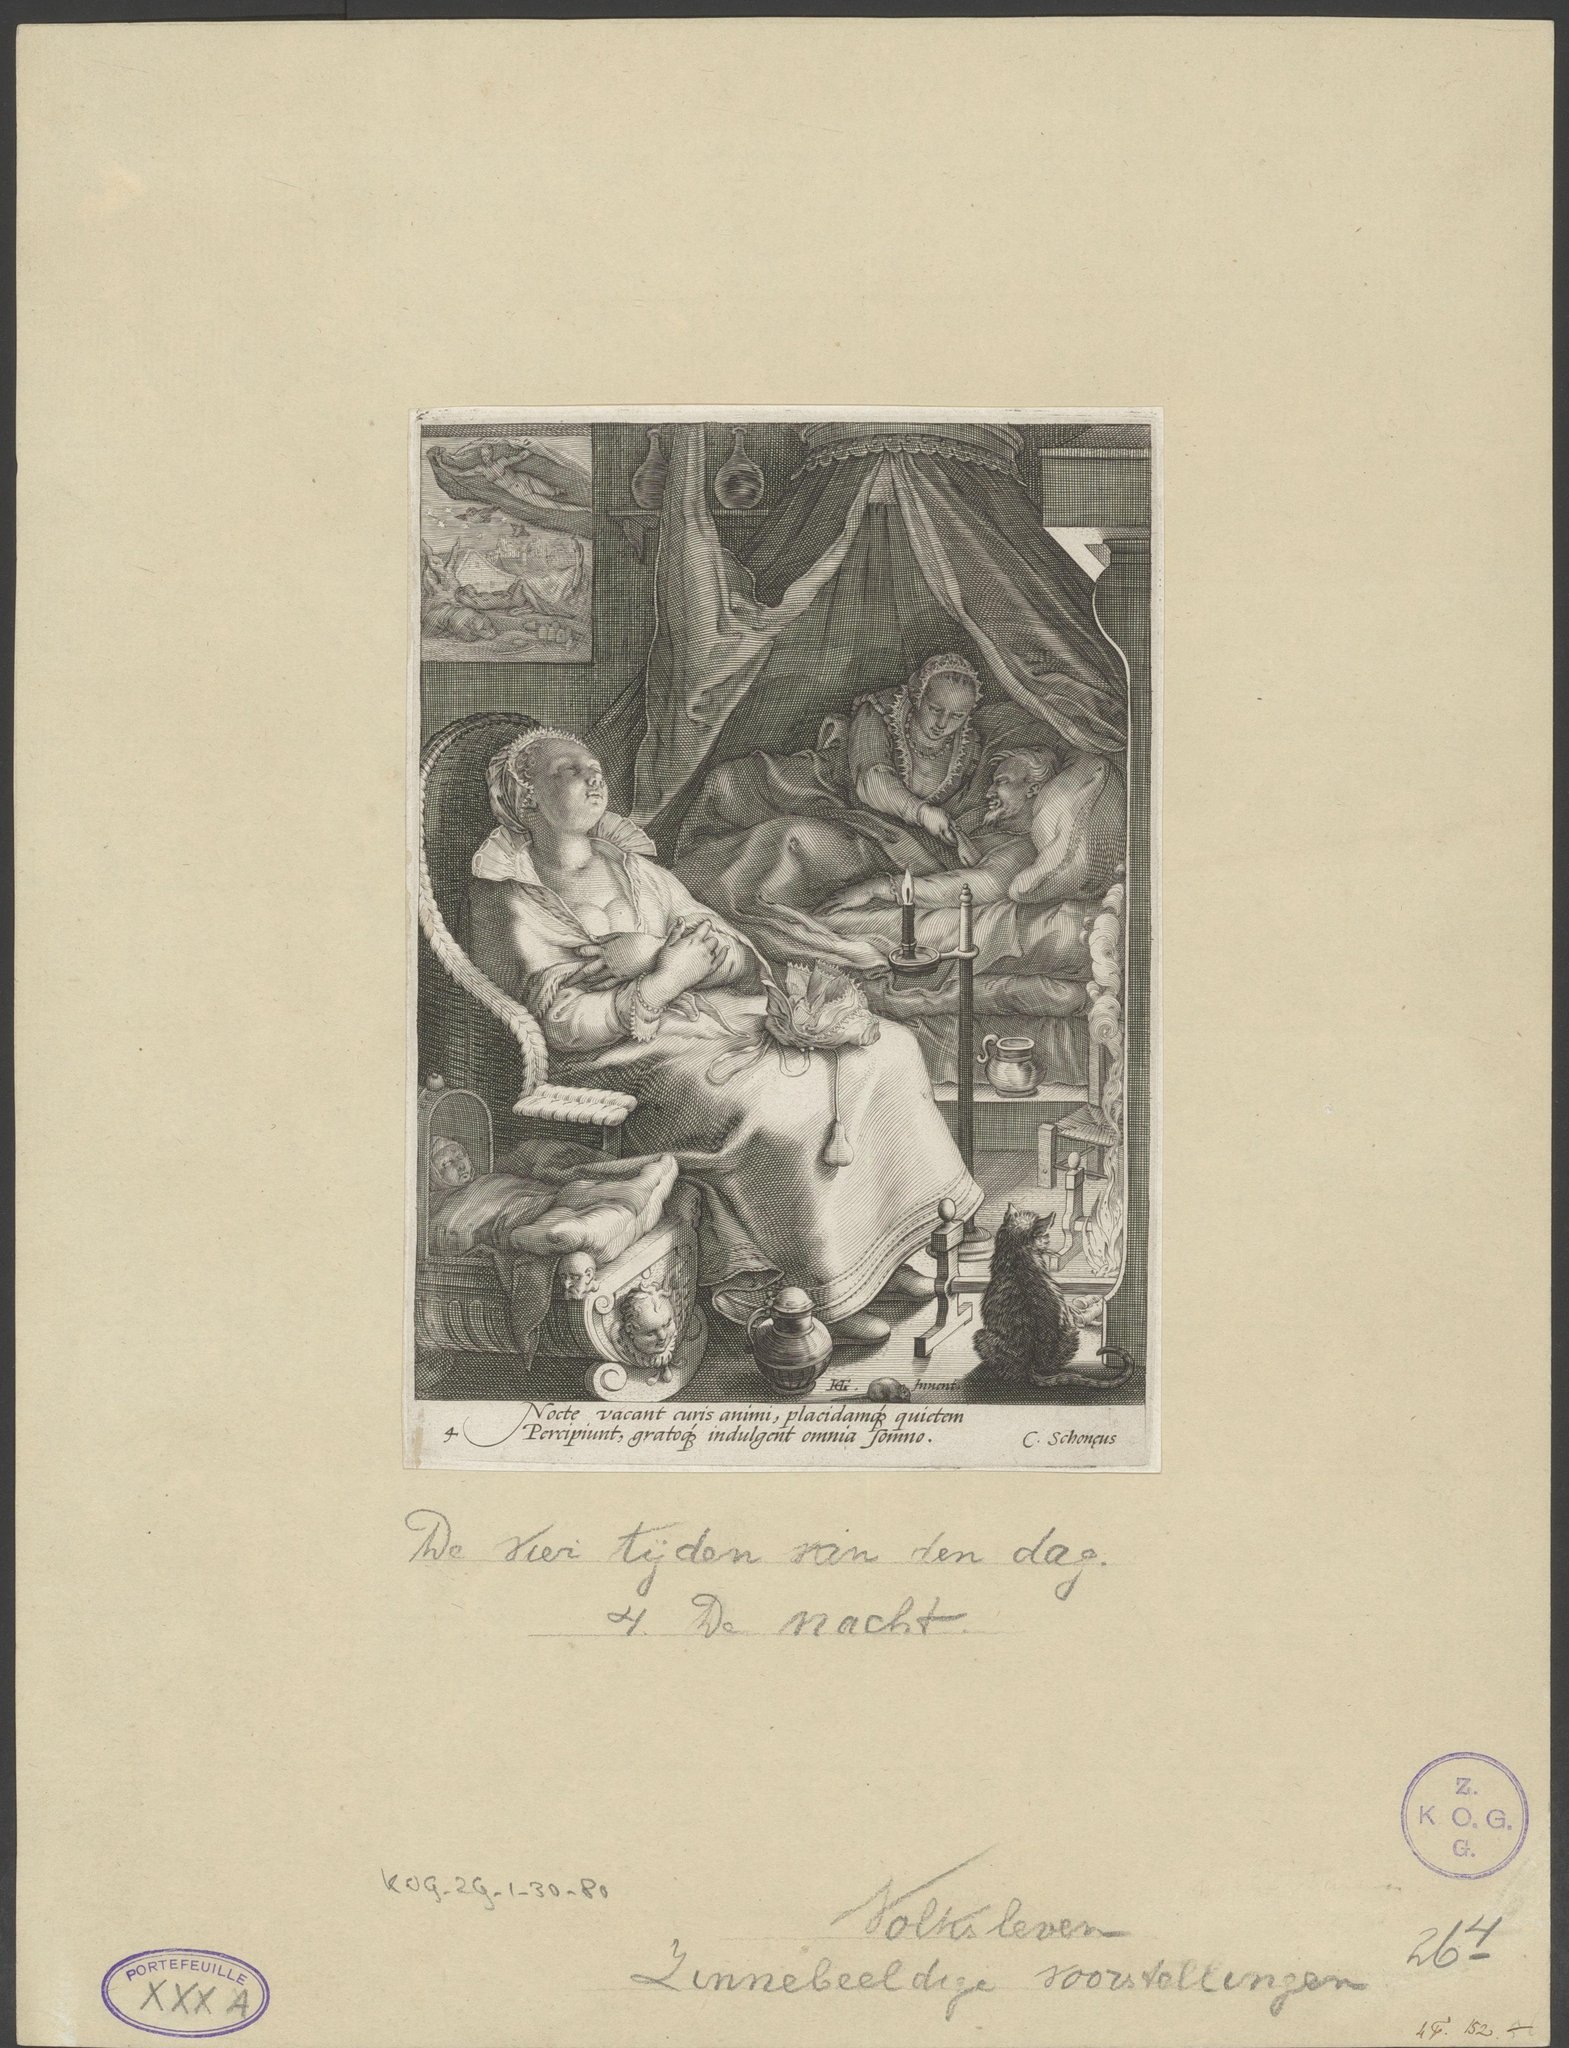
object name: print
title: Nacht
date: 1575-1607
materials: paper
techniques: engraving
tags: sleeping in chair, bed with tester, personification of the night, 'nox'; 'notte', 'carro della notte', 'serenità della notte' (ripa), sleeping in bed, cradle, crib, night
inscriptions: collector's mark: Lugt 963, collector's mark: Lugt 1641, stamp:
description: Slapende mensen in een vertrek. Op de voorgrond ligt een vrouw te slapen in een rieten leunstoel. Naast haar een slapende baby in een wieg. Achter in het vertrek een hemelbed met een slapende man en een vrouw die hem toestopt. Door een open venster is Nox in de wolken te zien. Onderaan een tweeregelig vers in het Latijn. Rechtsonder genummerd: 4. Onderwerpsrubrieken binnen de Atlas Zeden en Gewoonten: Zeden en Gewoonten in engeren zin. Volksleven. Zinnebeeldige voorstellingen uit het volkleven op serieprenten. Maanden en diversen (allegorieën).